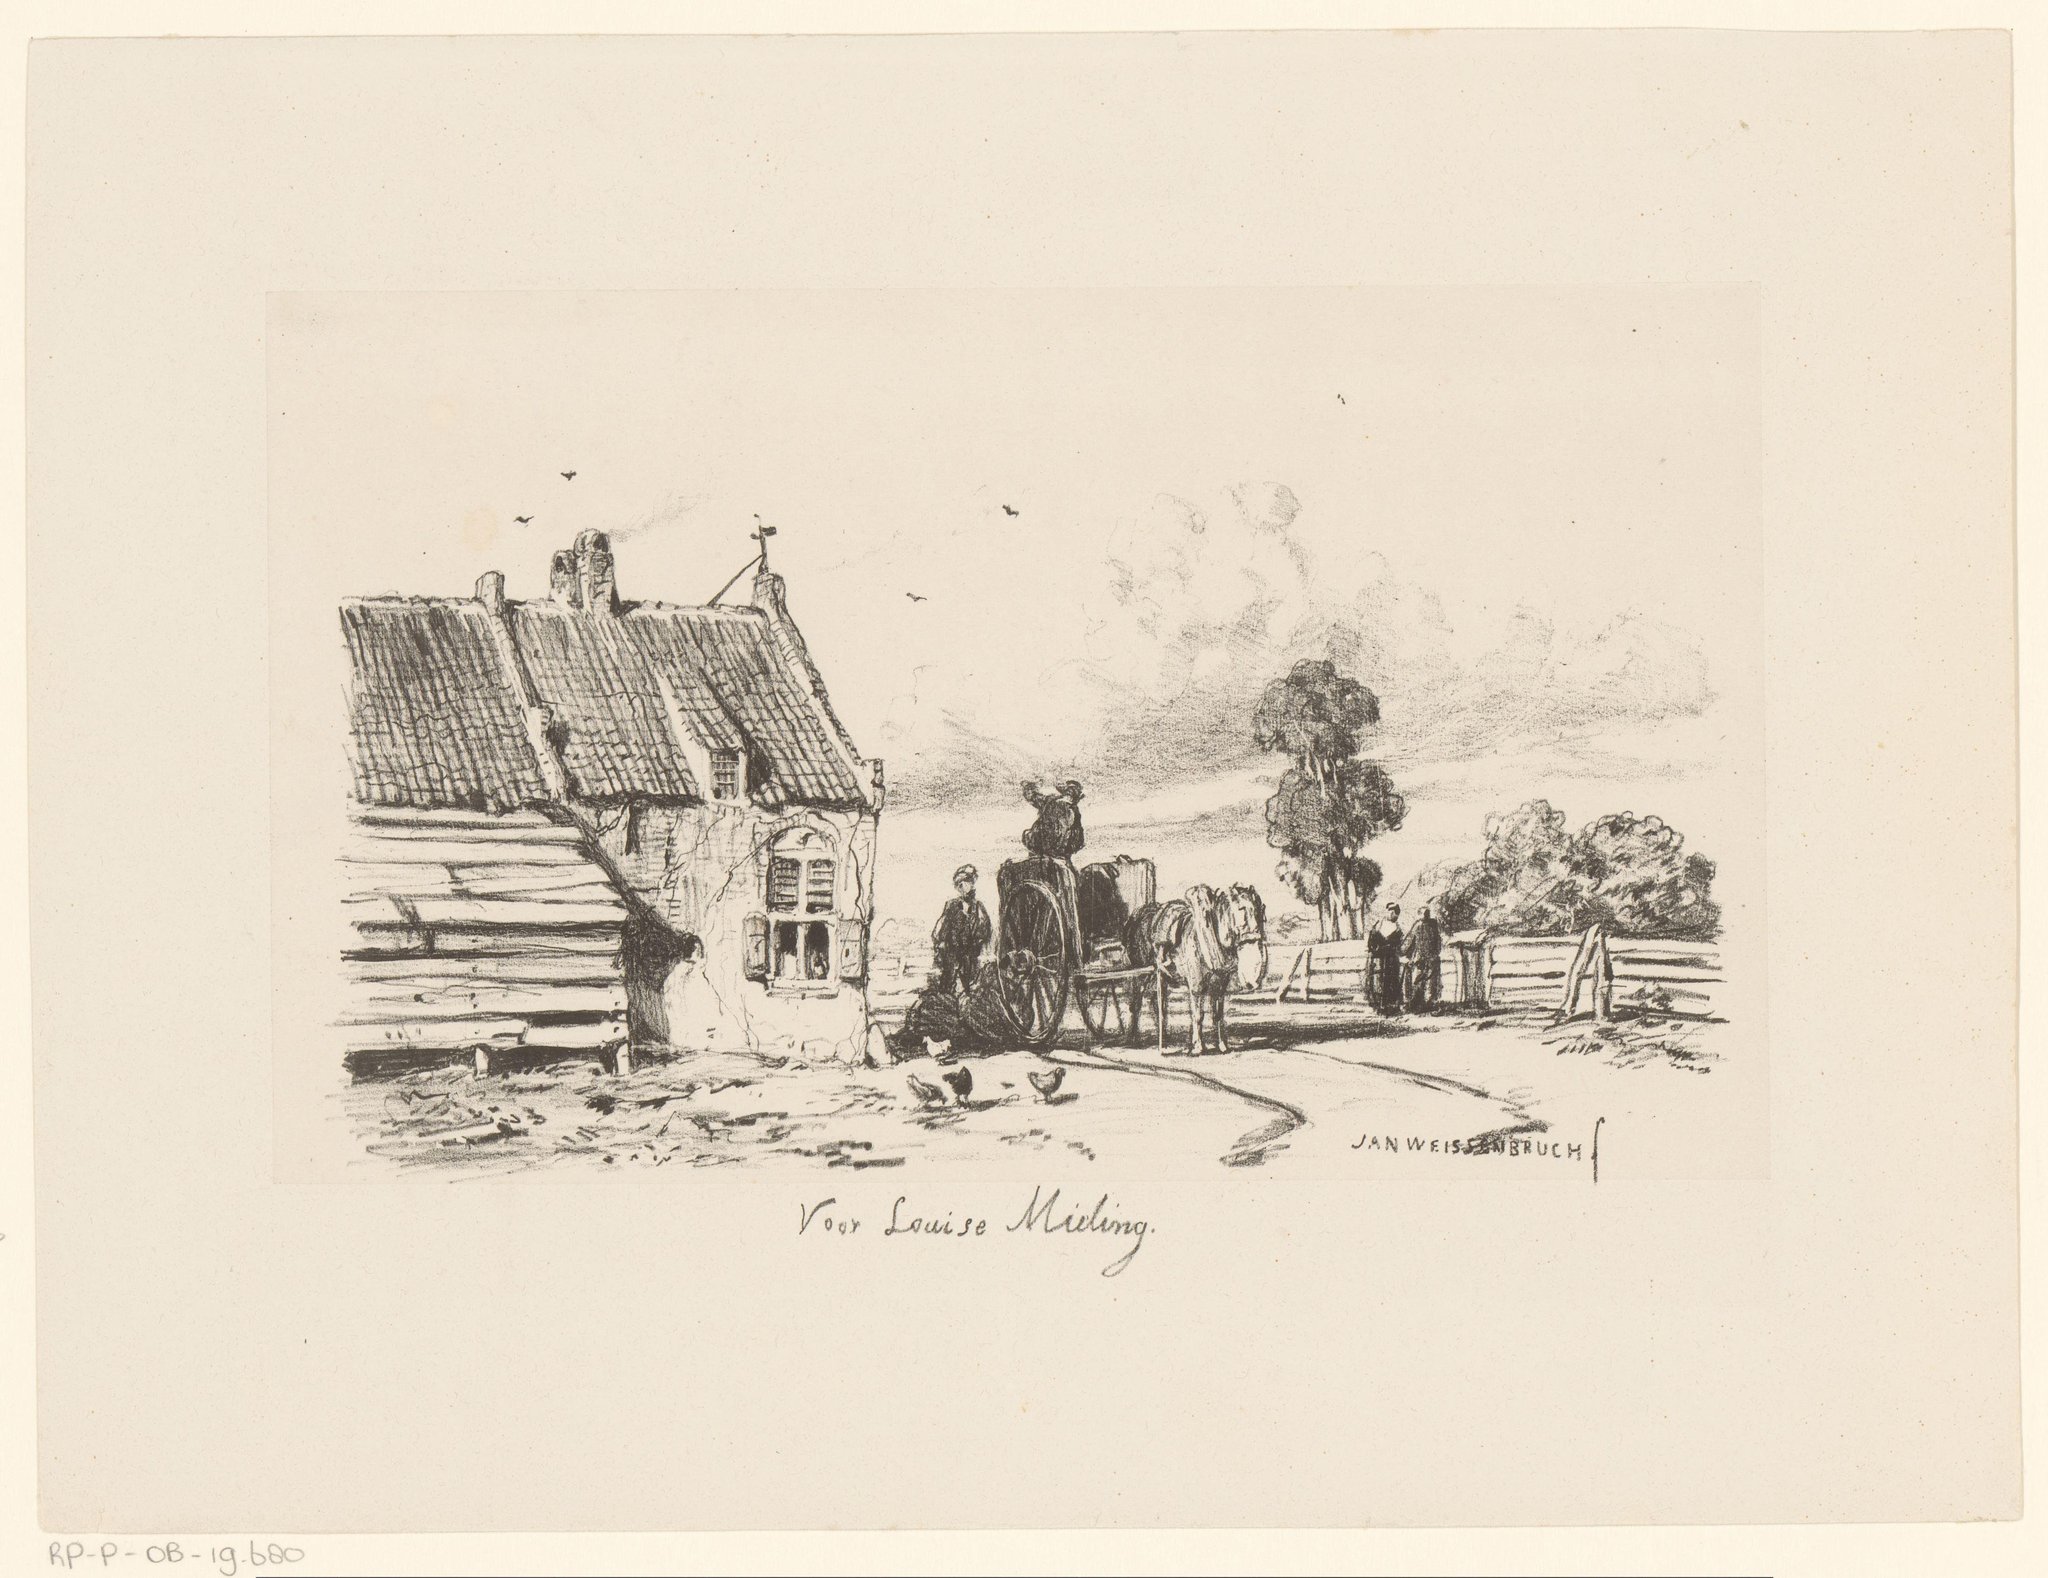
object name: print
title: Paard en wagen bij boerderij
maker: louise mieling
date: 1832-1880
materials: paper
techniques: lithograph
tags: animal traction, animal-drawn vehicle (carriage etc.), farm or solitary house in landscape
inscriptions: collector's mark: Lugt 2228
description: Rechts van een boerderij staan figuren bij een paard en wagen.